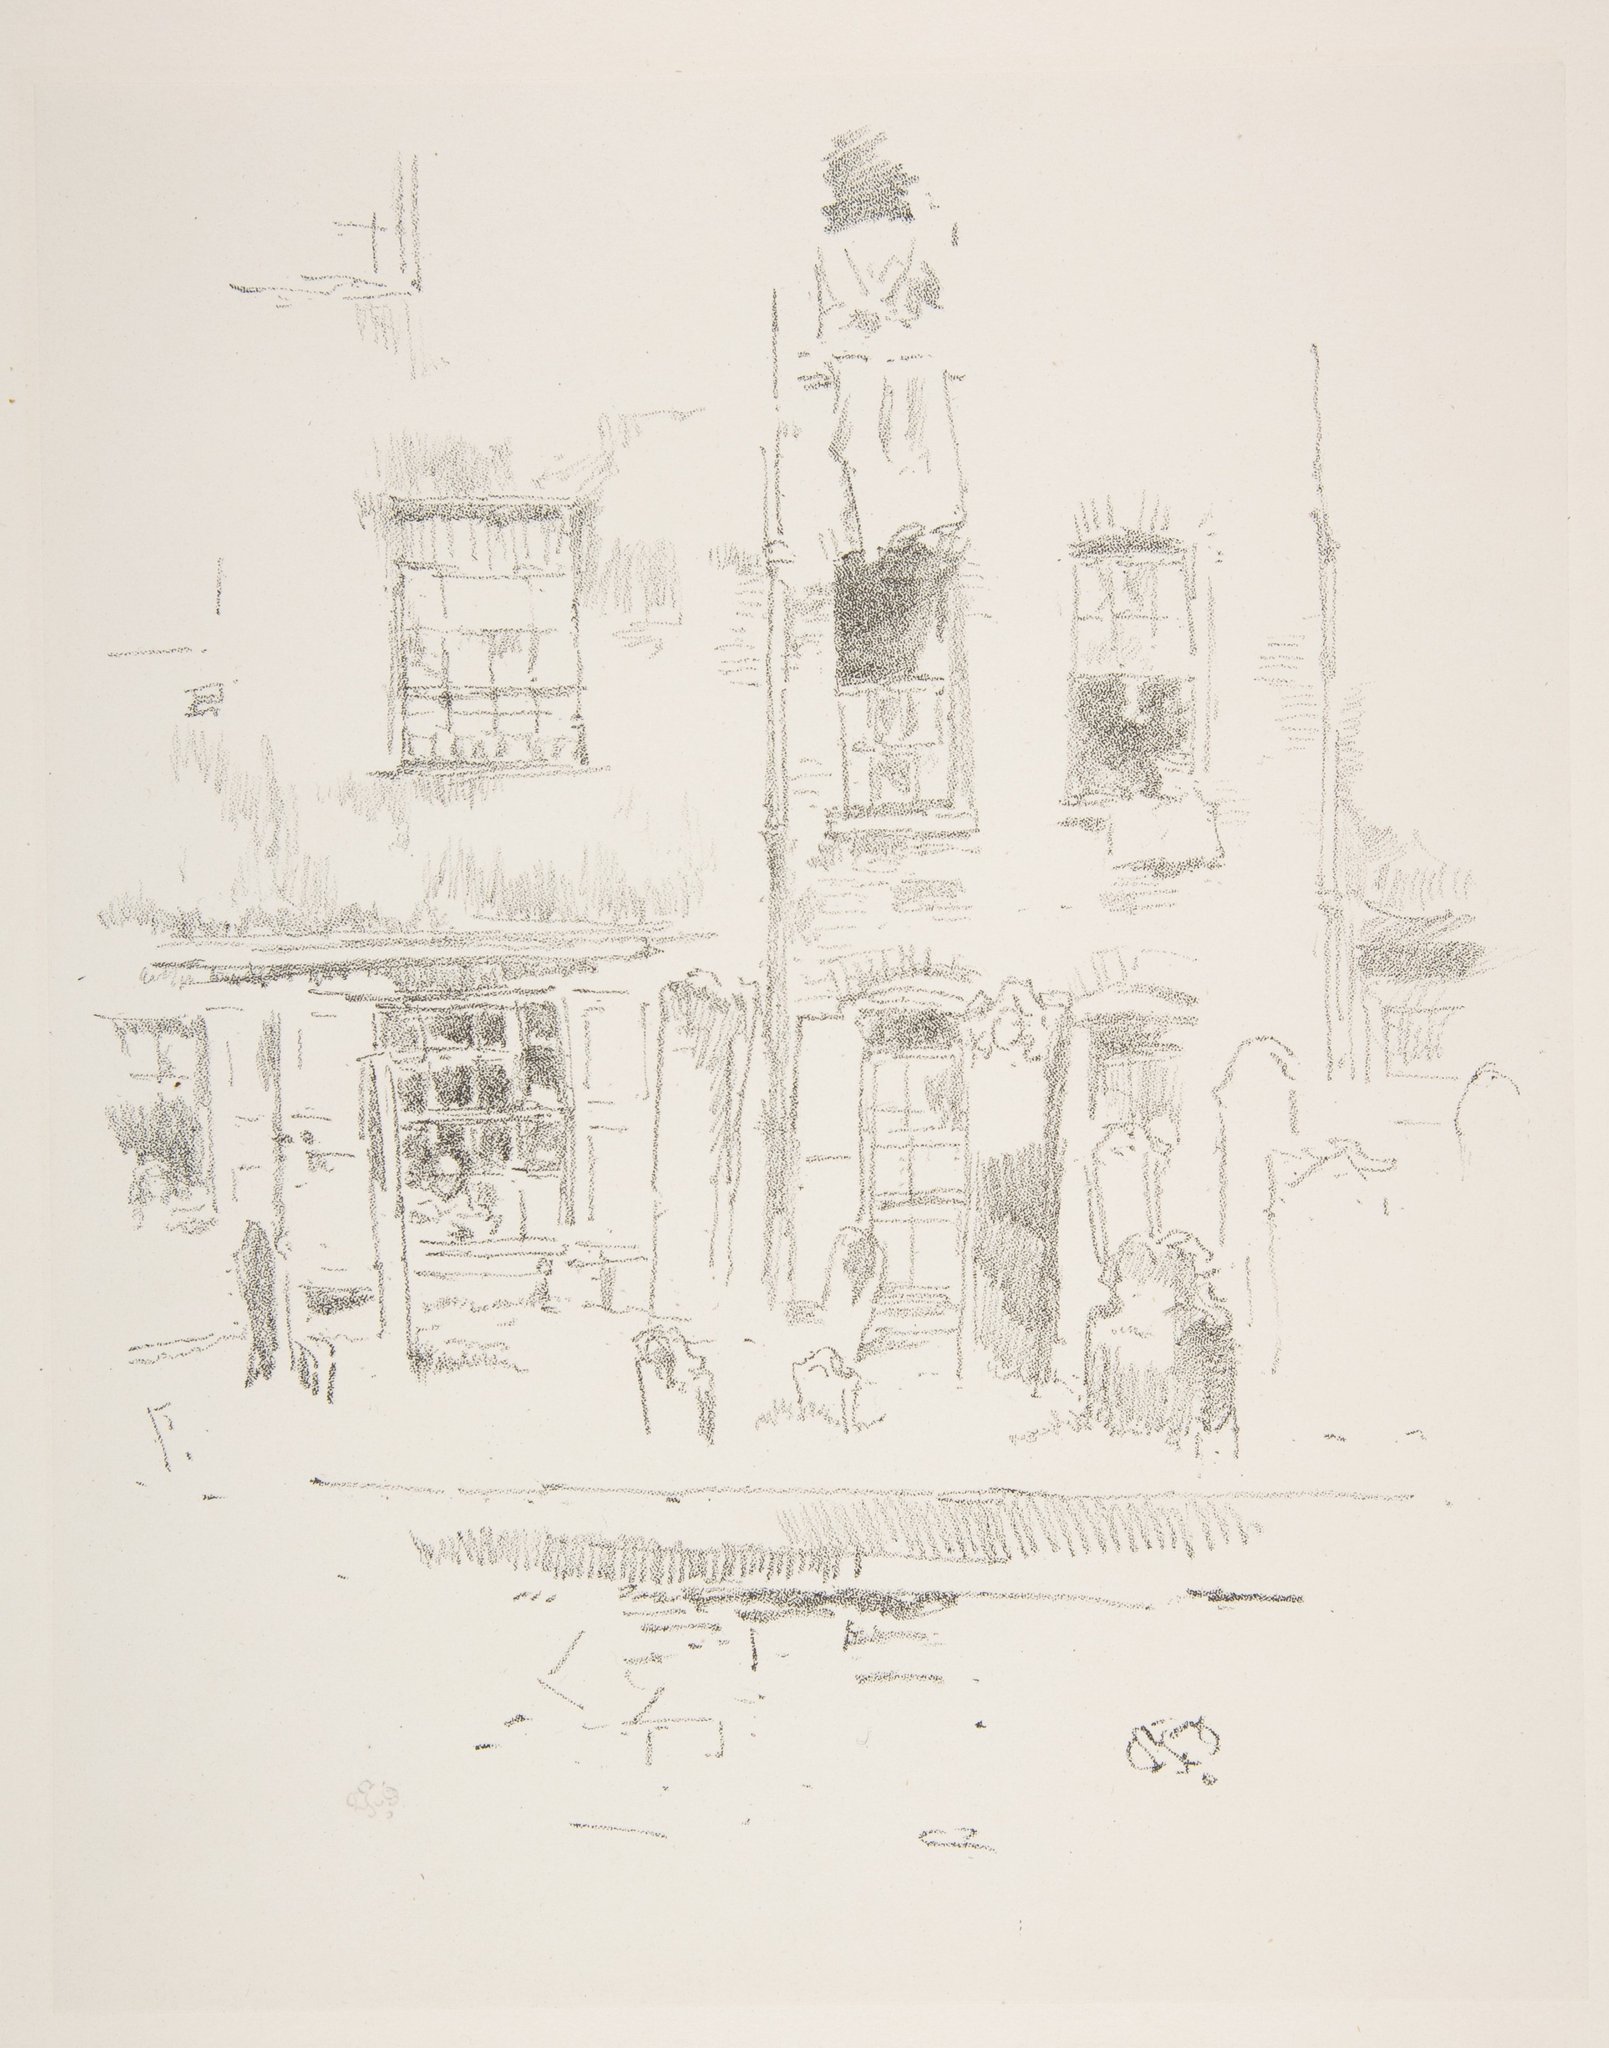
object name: print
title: Churchyard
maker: james mcneill whistler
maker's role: artist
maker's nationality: american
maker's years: 1834-1903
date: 1887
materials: chine, paper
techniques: lithography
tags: burial grounds